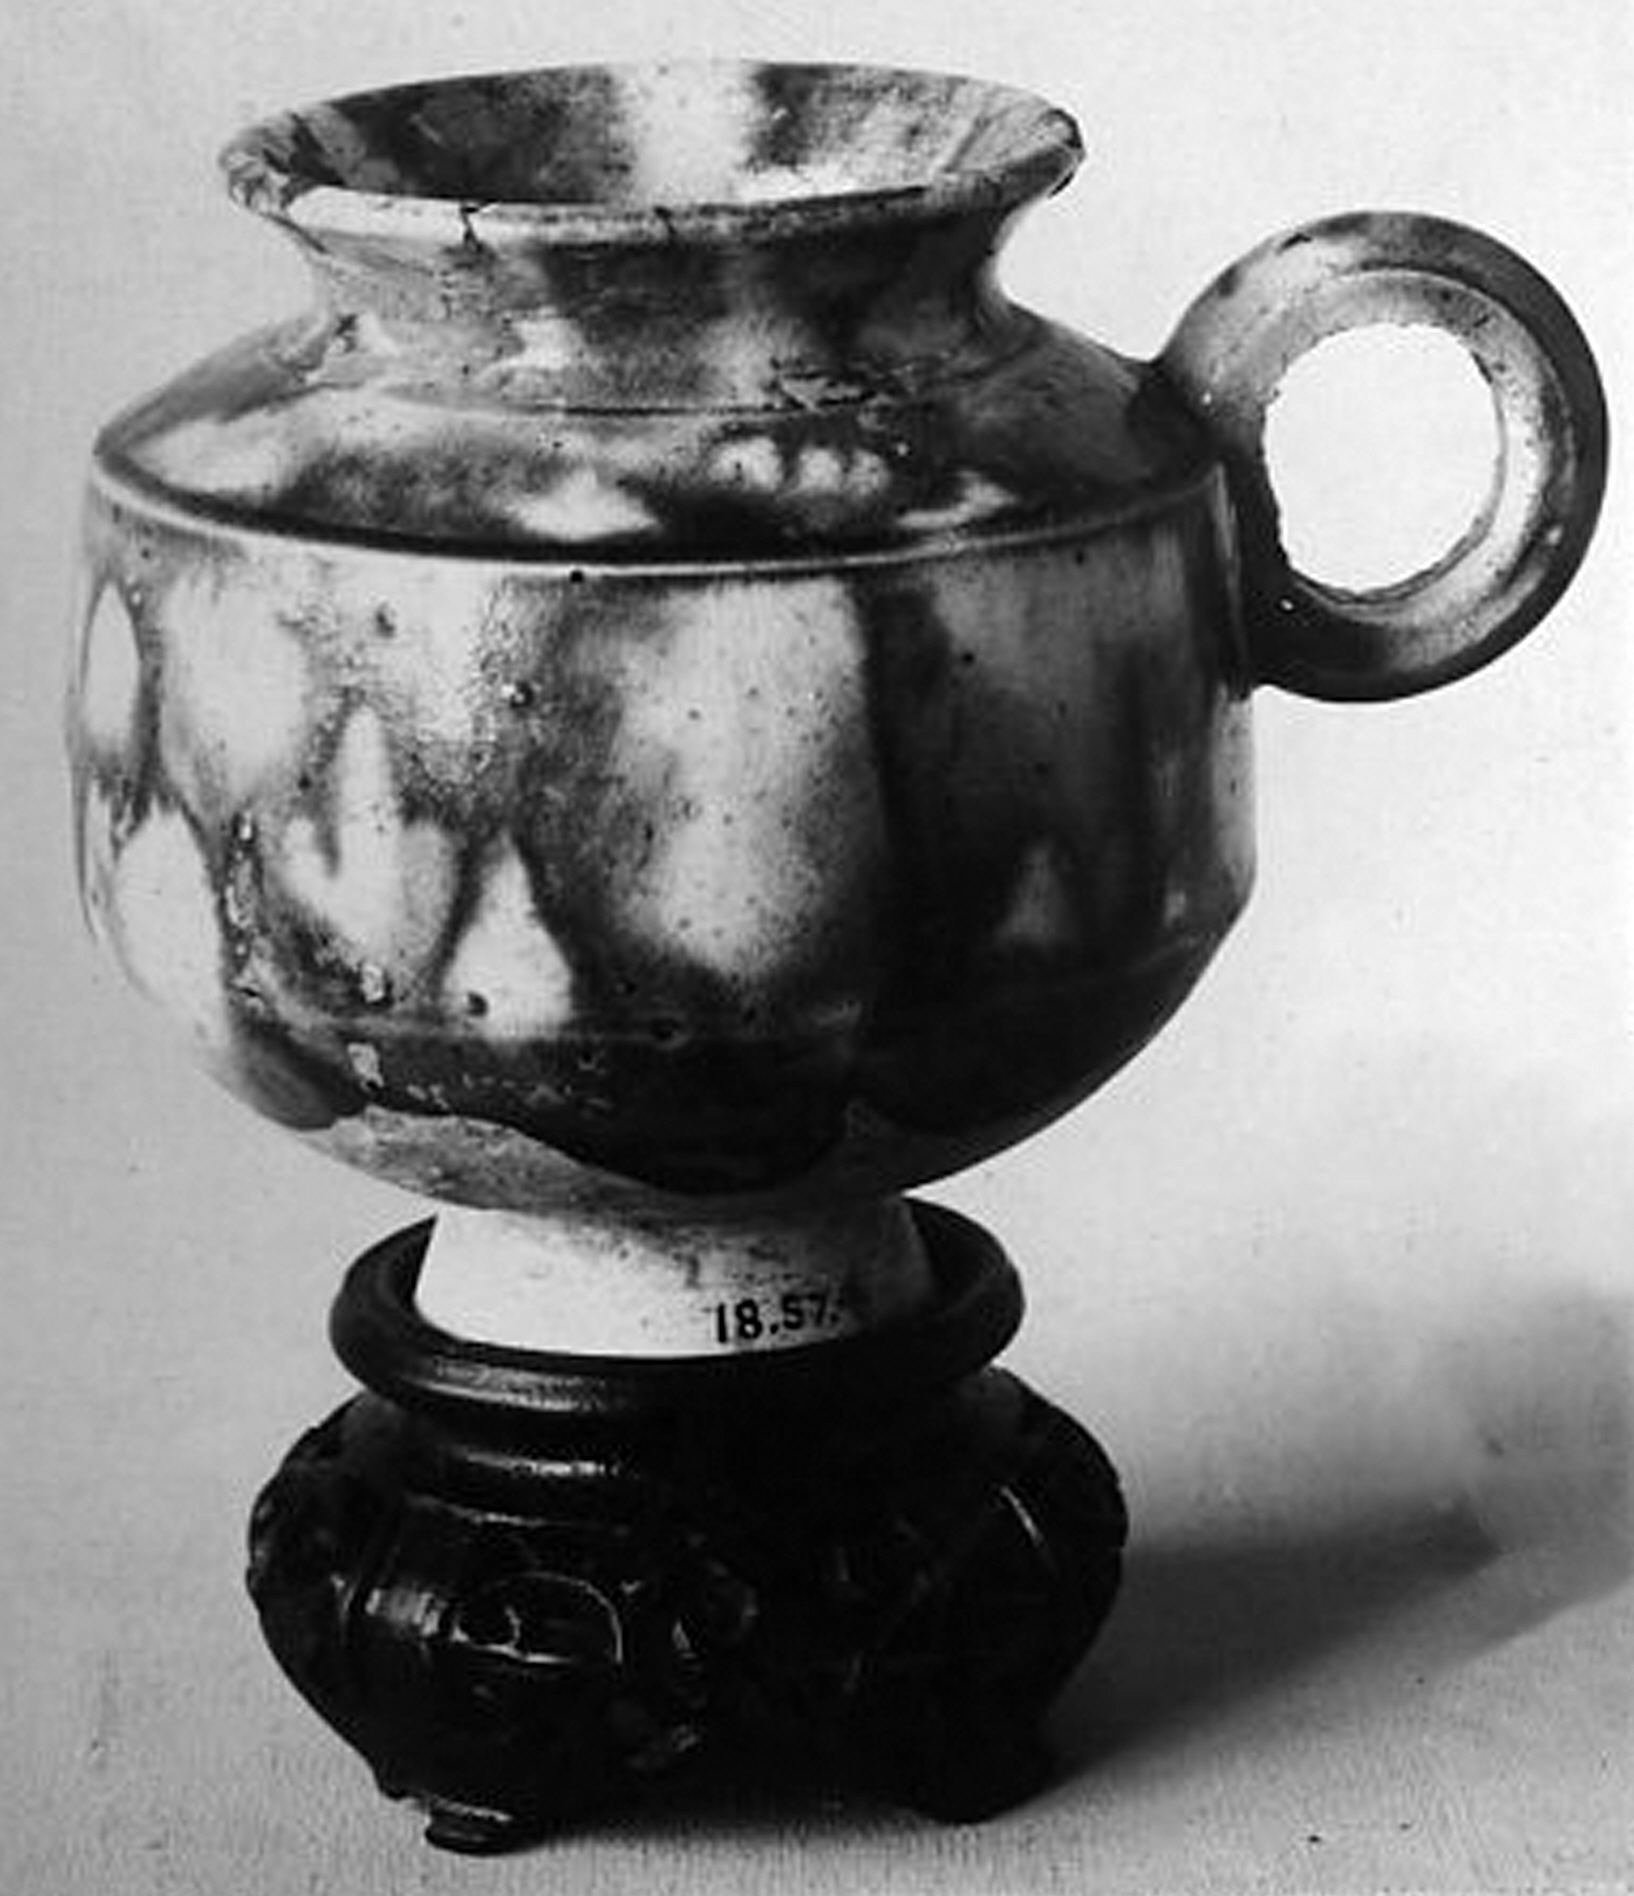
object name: jar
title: Jar with handle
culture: chinese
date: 701-800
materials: earthenware, glaze